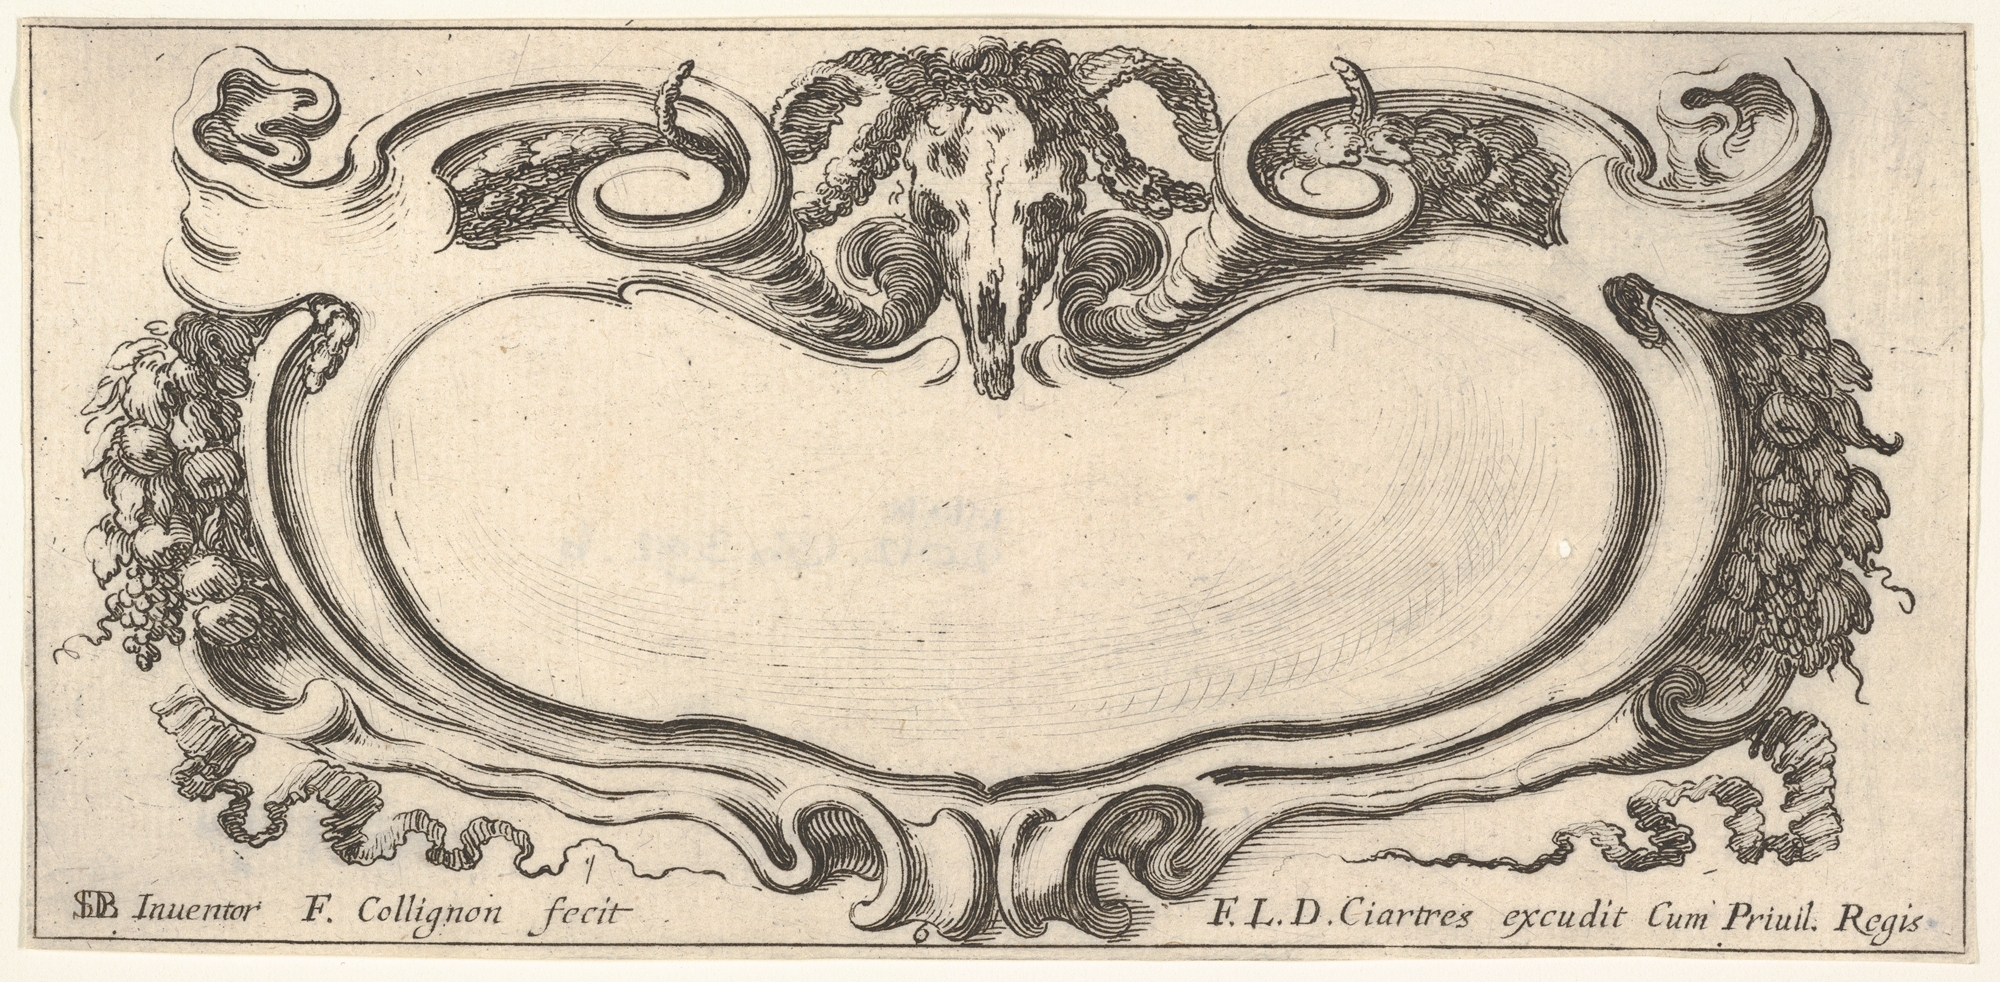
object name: print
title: Plate 6: a cartouche with a ram skull at top center, grapes and other fruits to either side, from "Twelve cartouches" (Recueil de douze cartouches)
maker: françois collignon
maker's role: artist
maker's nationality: french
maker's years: 1605-1687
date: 1640-1645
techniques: etching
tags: cartouches,grapes,skulls,rams